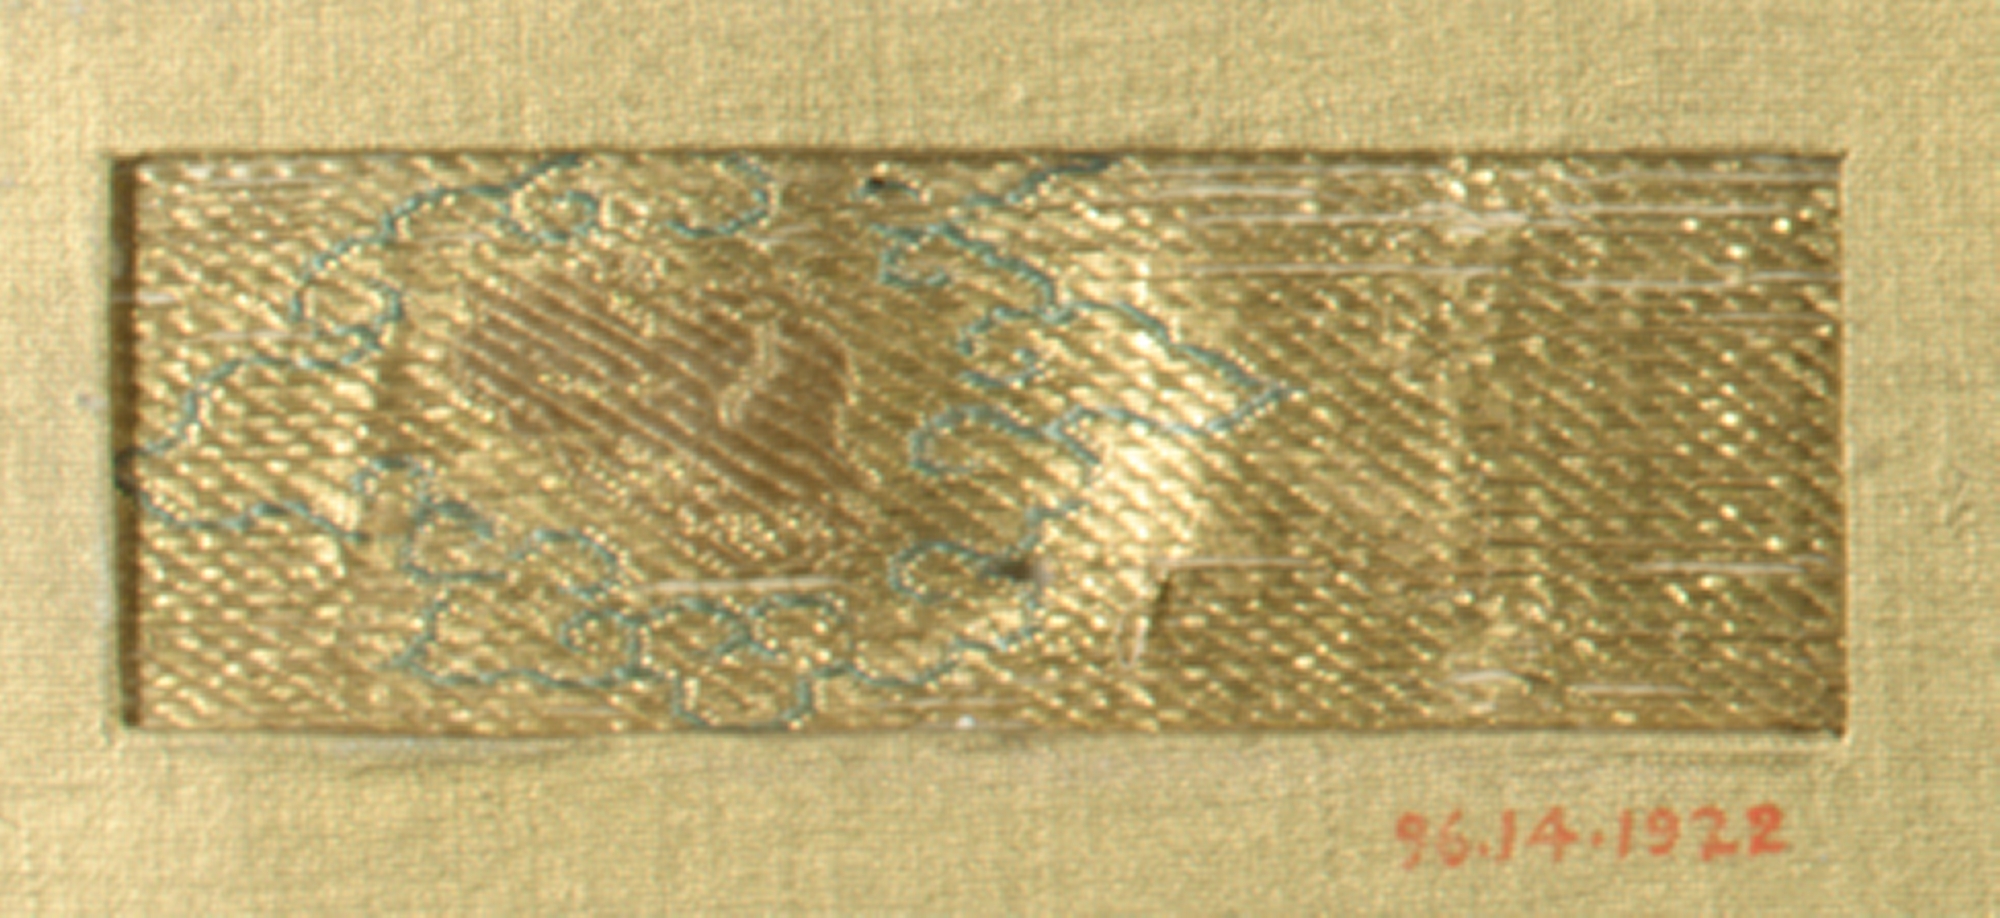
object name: piece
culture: japanese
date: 1701-1900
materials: silk